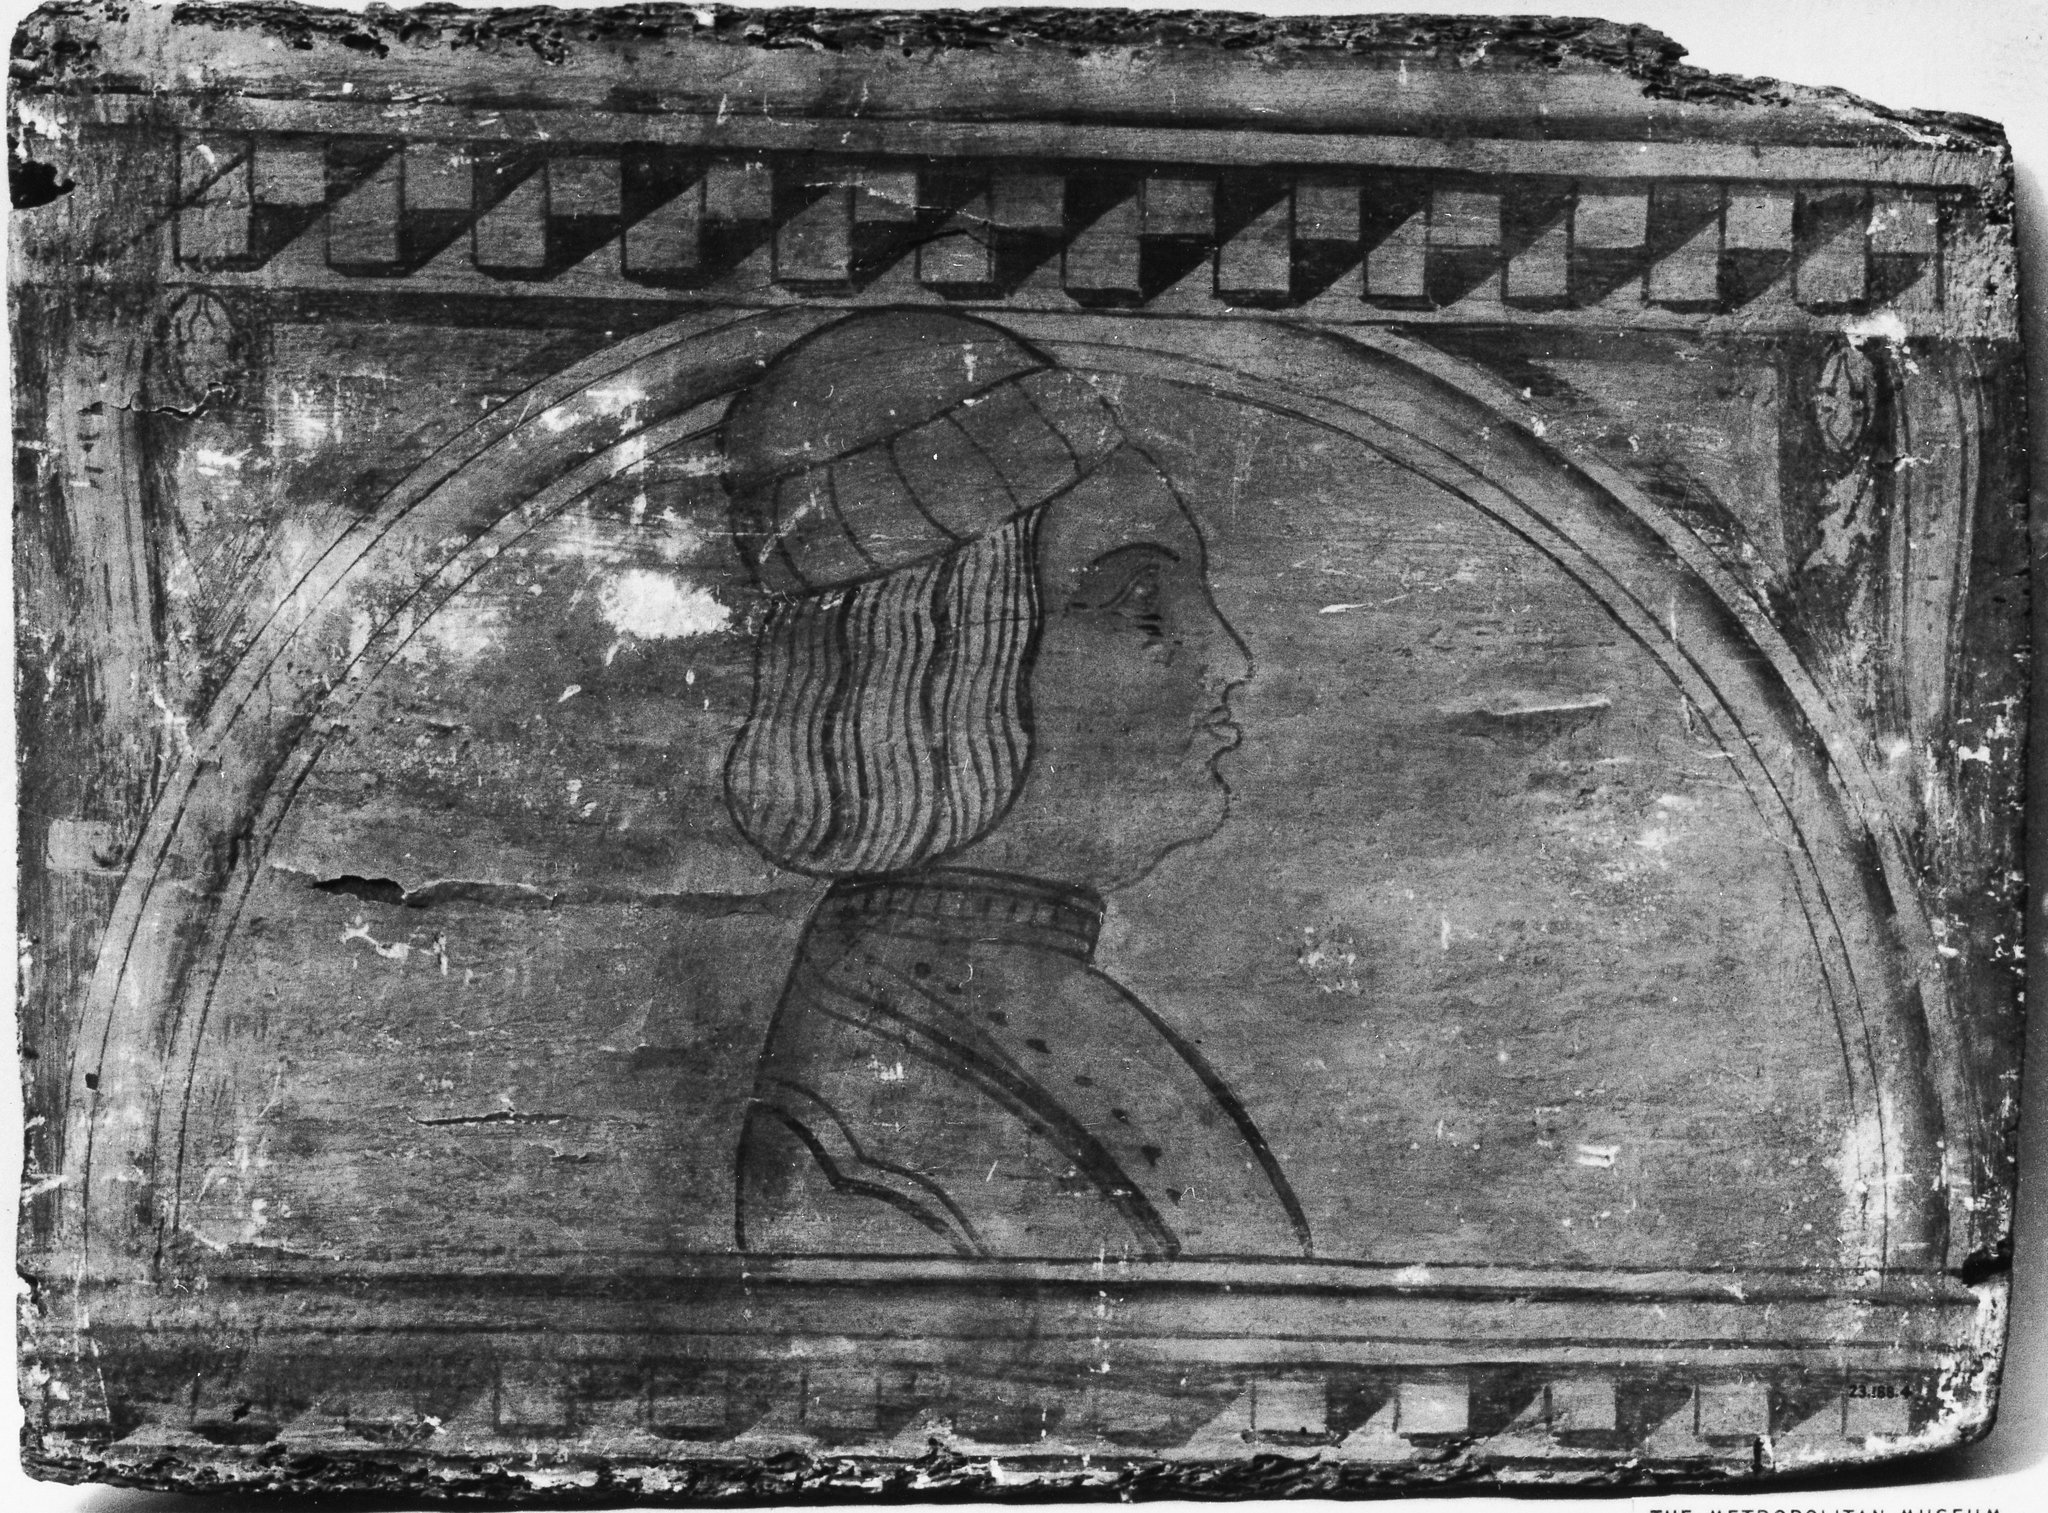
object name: frieze panel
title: Head of a man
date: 1501-1533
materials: paint, wood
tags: men,profiles